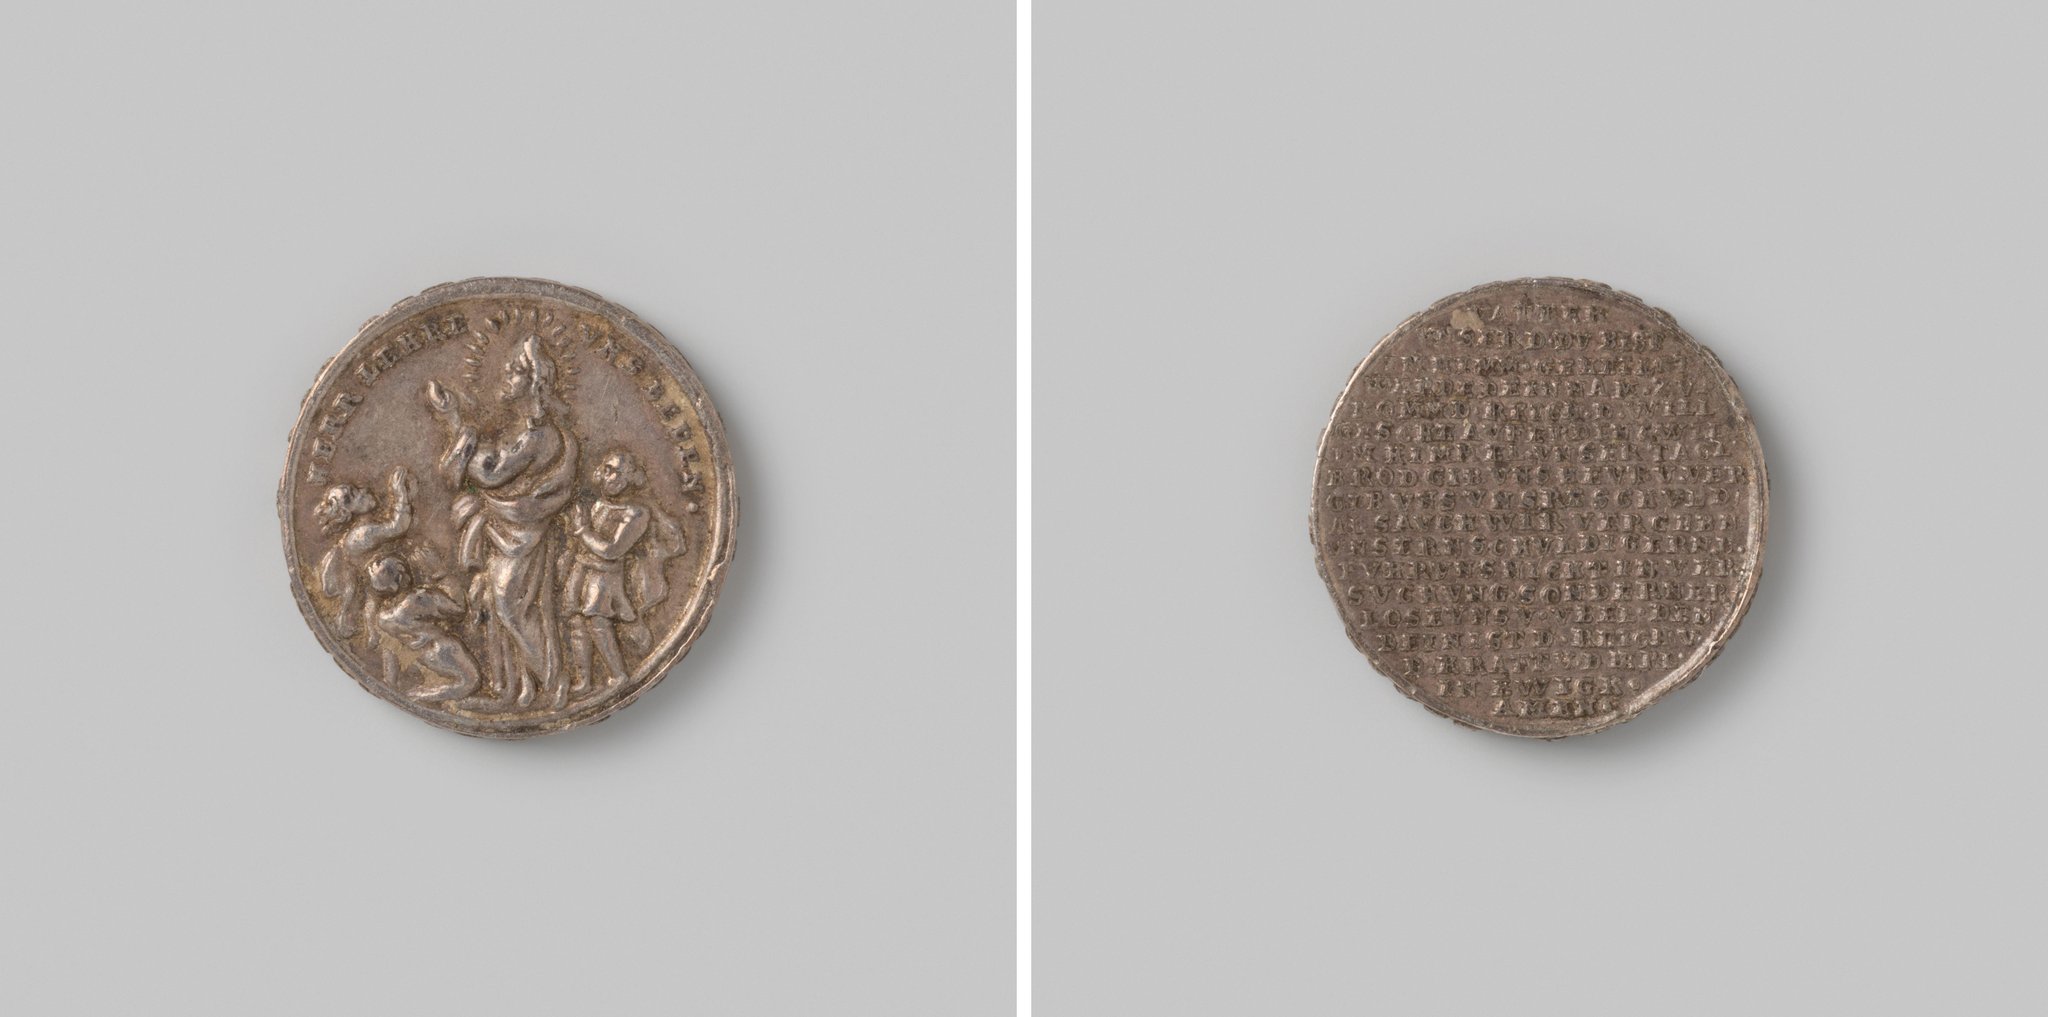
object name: history medal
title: Duitse miniatuurpenning met Onze Vader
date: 1600-1750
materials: silver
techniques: striking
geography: germany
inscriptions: inscription: ‘WENN IHR BETET SO SPRECHT . LVCE XI .’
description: Kleine zilveren penning, op de voorzijde Jesus met drie biddende volgelingen, met omschrift, op de keerzijde het Onze Vader in achttien regels, met opstaand randschrift